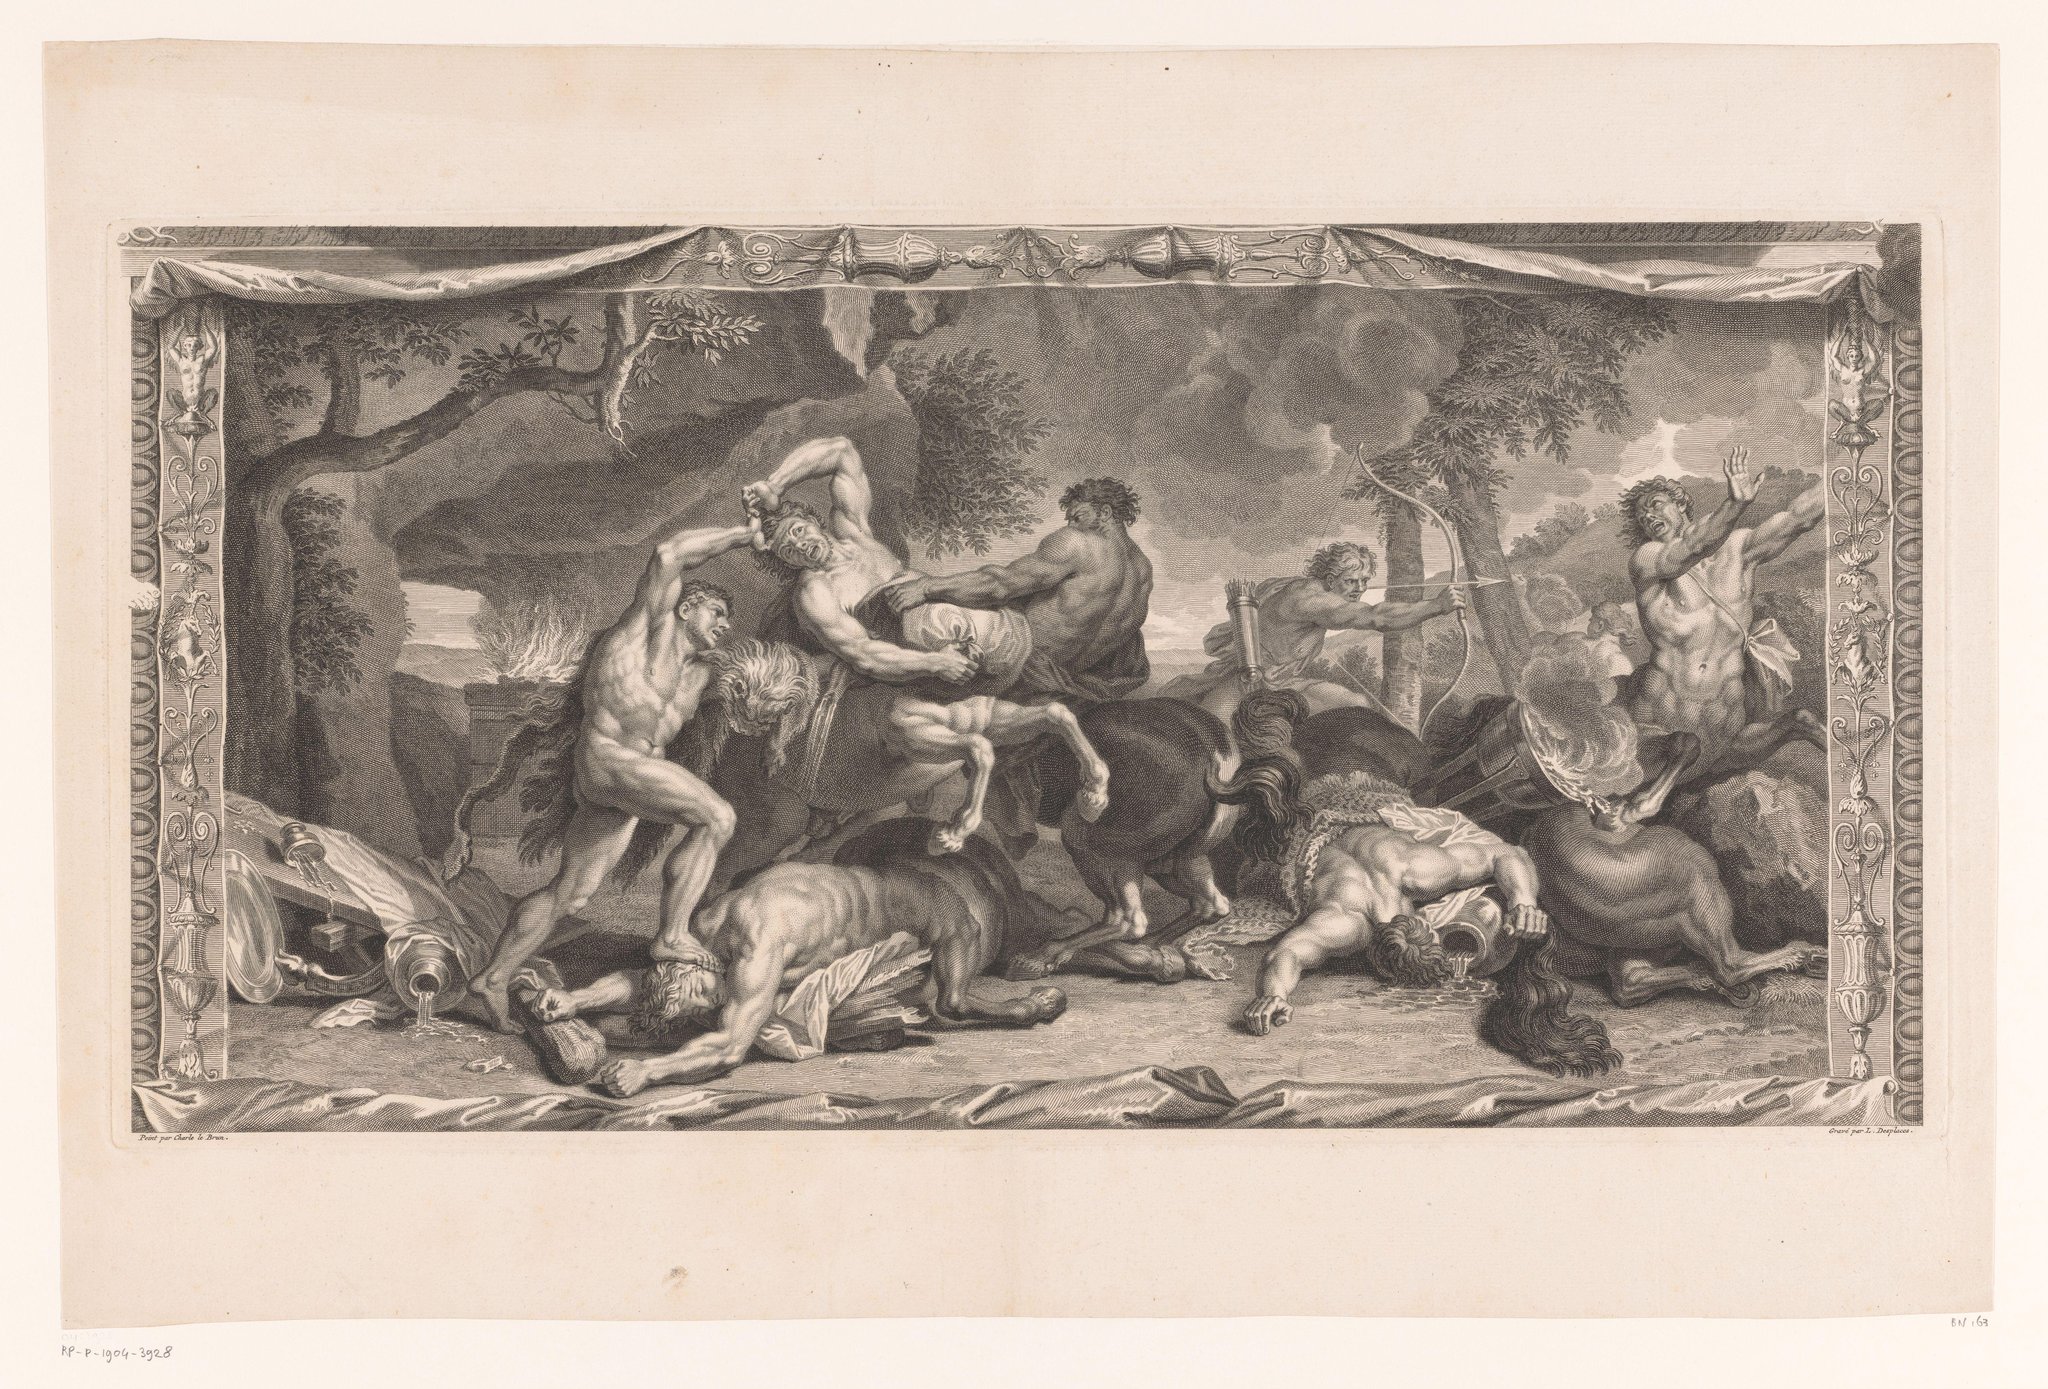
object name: print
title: Les peintures de Charles le Brun et d'Eustache Le Sueur qui sont dans (...)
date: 1709-1740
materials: paper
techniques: engraving, etching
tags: hercules' fight with the centaurs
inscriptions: collector's mark: Lugt 2228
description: Maakt deel uit van een subserie getiteld 'La Galerie de monsieur le Président Lambert représentant l'apothéose d'Hercule' met prenten naar plafondschilderingen door Le Brun voor het Hôtel Lambert te Parijs. De subserie maakt tevens deel uit van een grotere serie getiteld 'Les Peintures de Charles Le Brun et d'Eustache Le Sueur (...)', uitgegeven door Duchange in 1740.